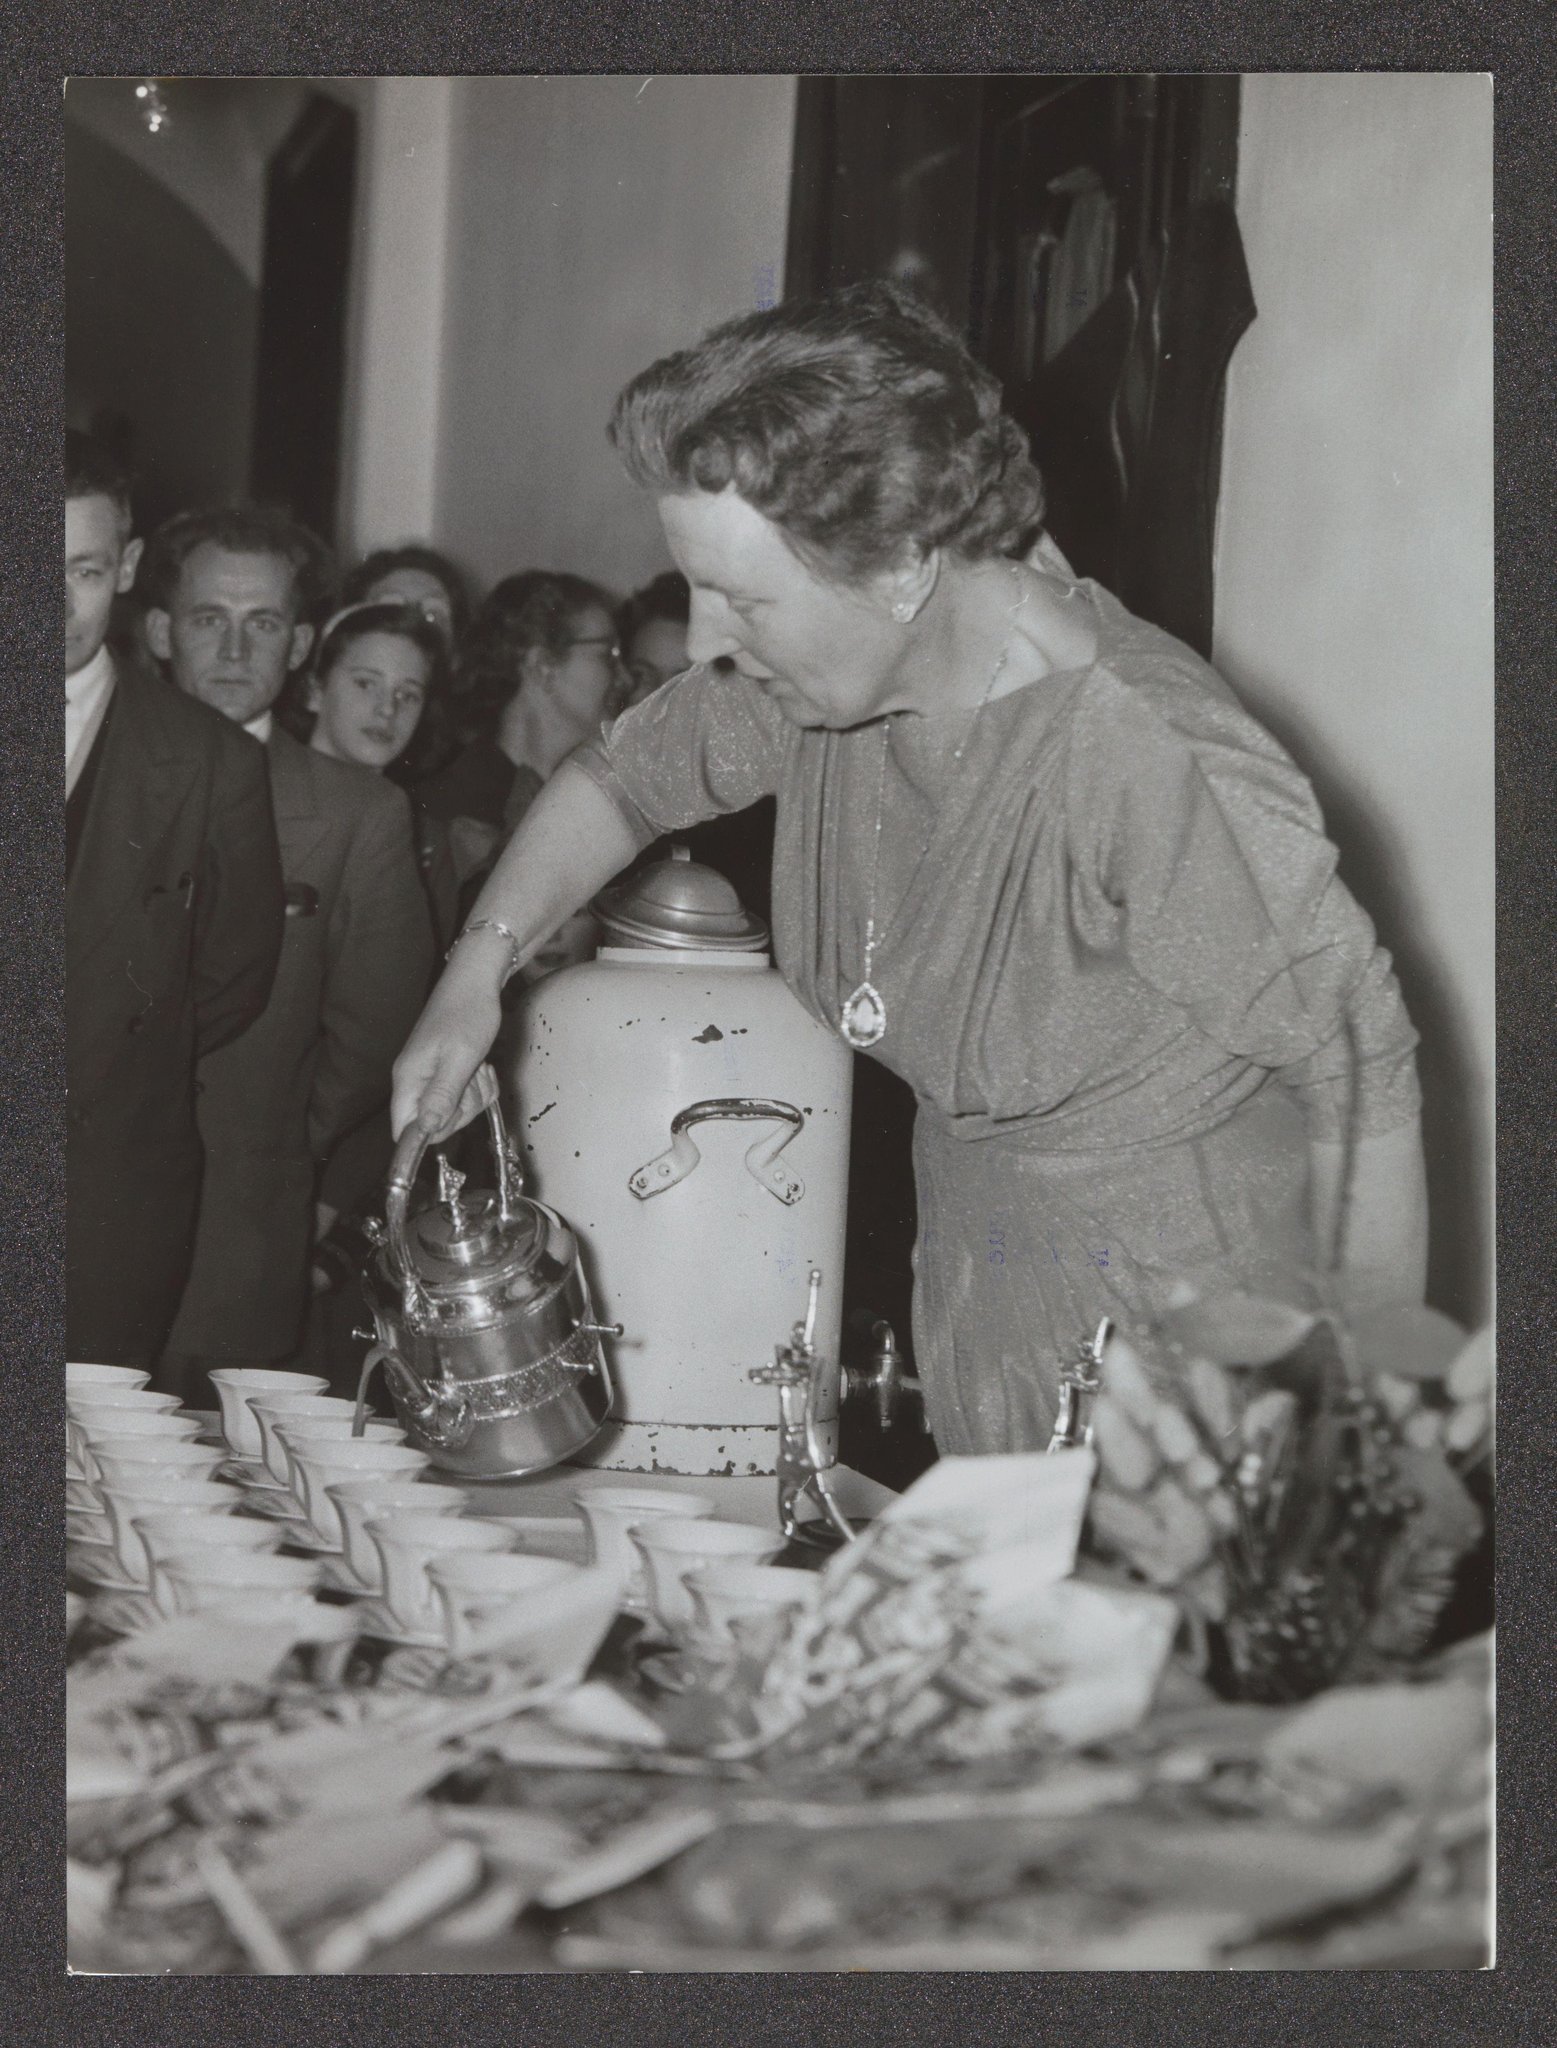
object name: photograph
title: Koningin Juliana schenkt chocolademelk in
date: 1958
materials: cardboard, paper, photographic support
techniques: gelatin silver print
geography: netherlands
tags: juliana of the netherlands, the hague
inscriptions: annotation: ‘After the feast, which was organised for the personal of the palaces H.M. Queen Juliana gave the guests cups of chocolatemilk’